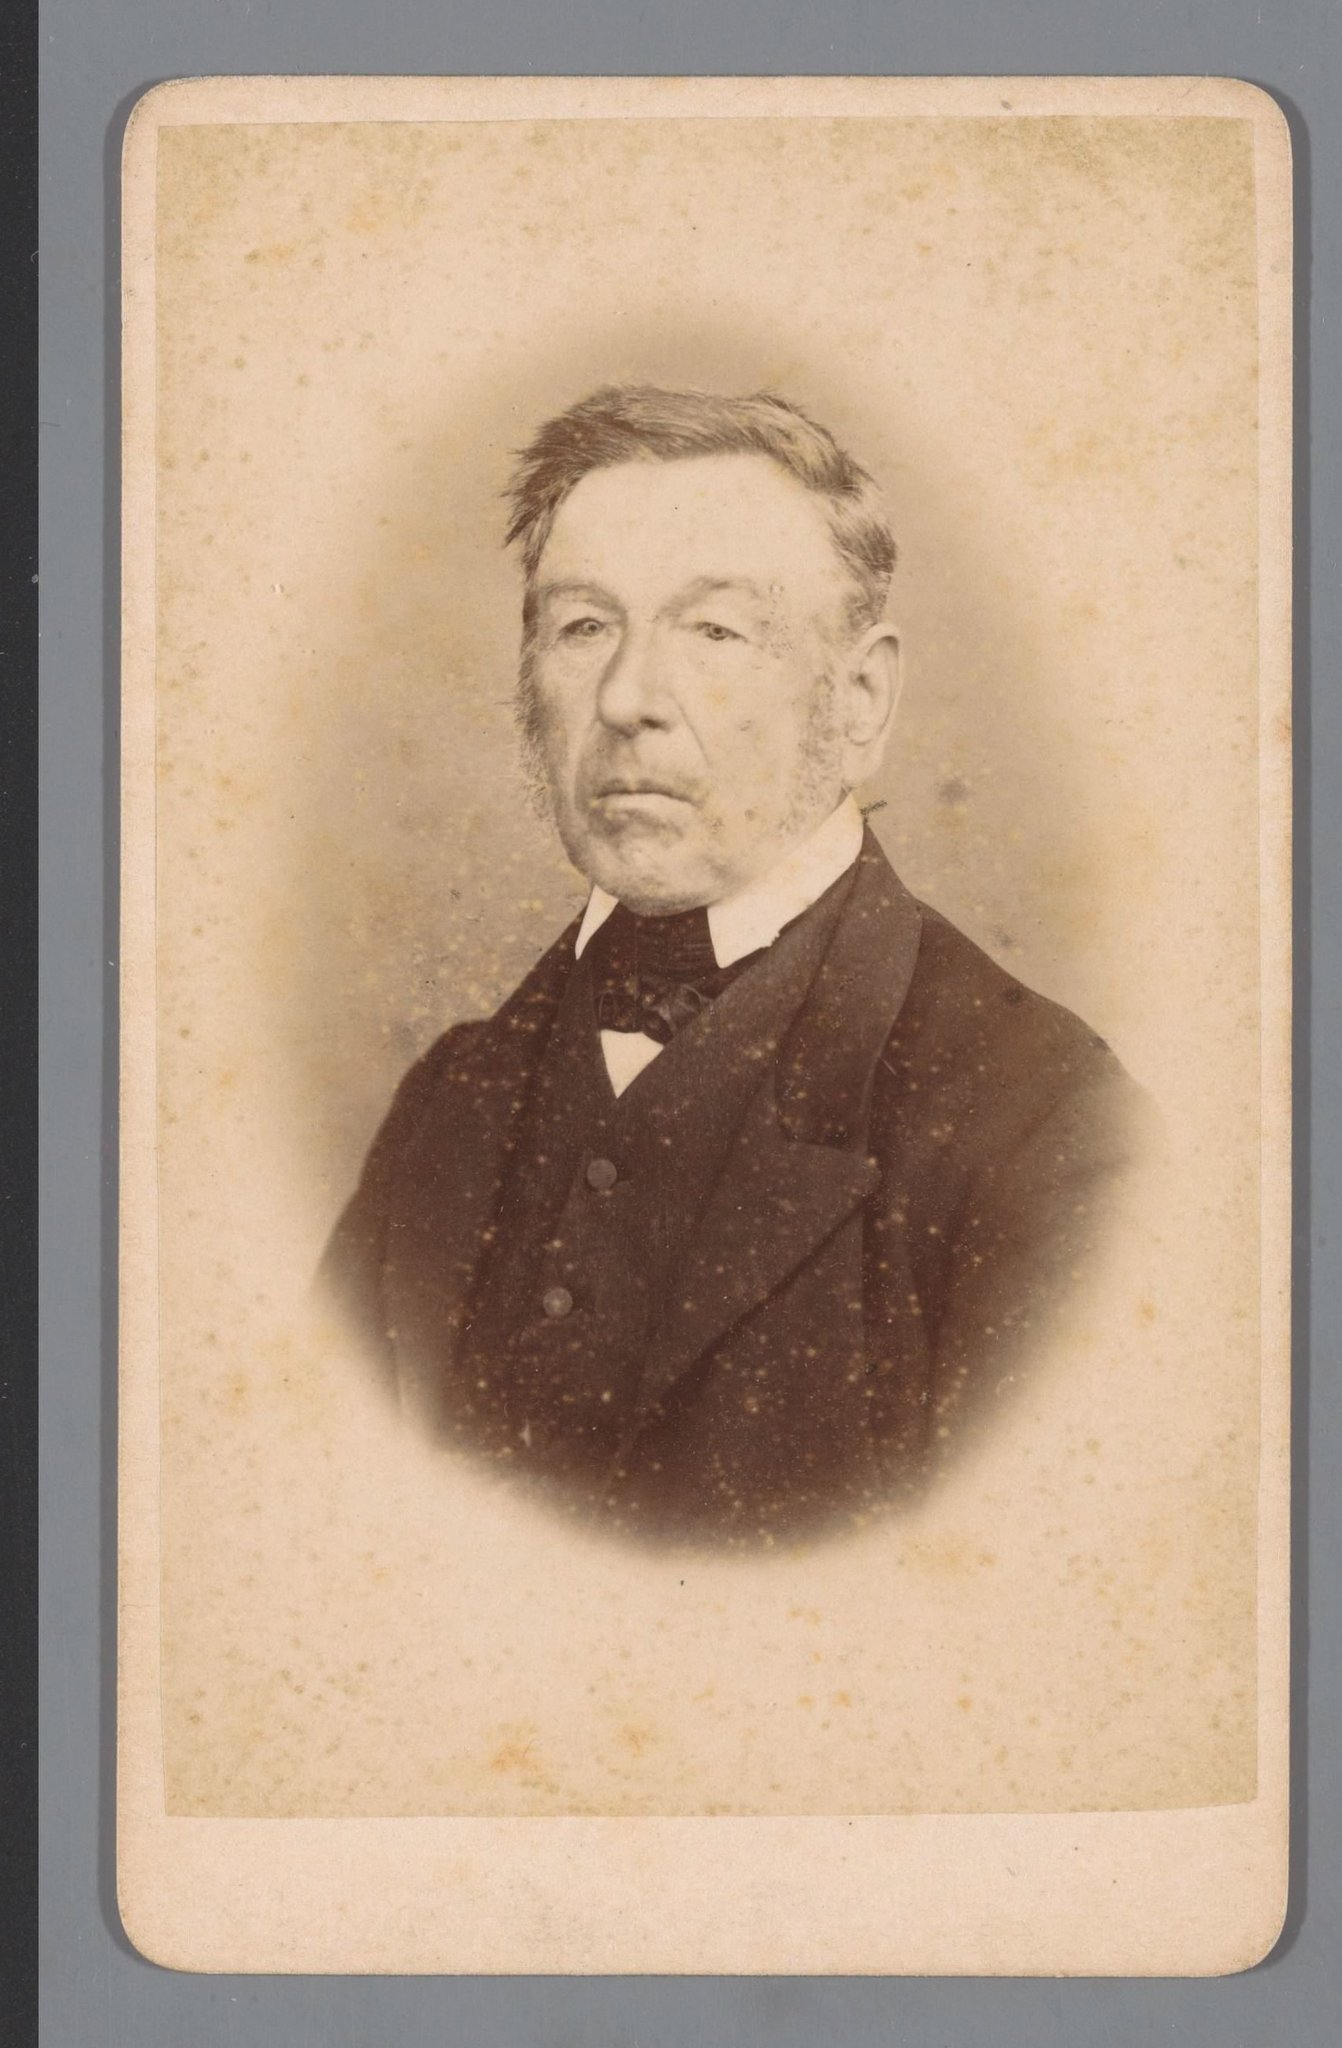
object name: carte de visite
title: Portret van een man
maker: veuve j. van koningsveld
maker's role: fotograaf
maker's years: 1828-1907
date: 1874-1876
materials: cardboard, paper, photographic support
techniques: albumen print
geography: deventer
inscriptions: annotation: ‘De plaat blijft tot nabestelling bewaard.’, address: ‘Wed.J. van Koningsveld/Boterstraat/Deventer/en/Scheveningen.’